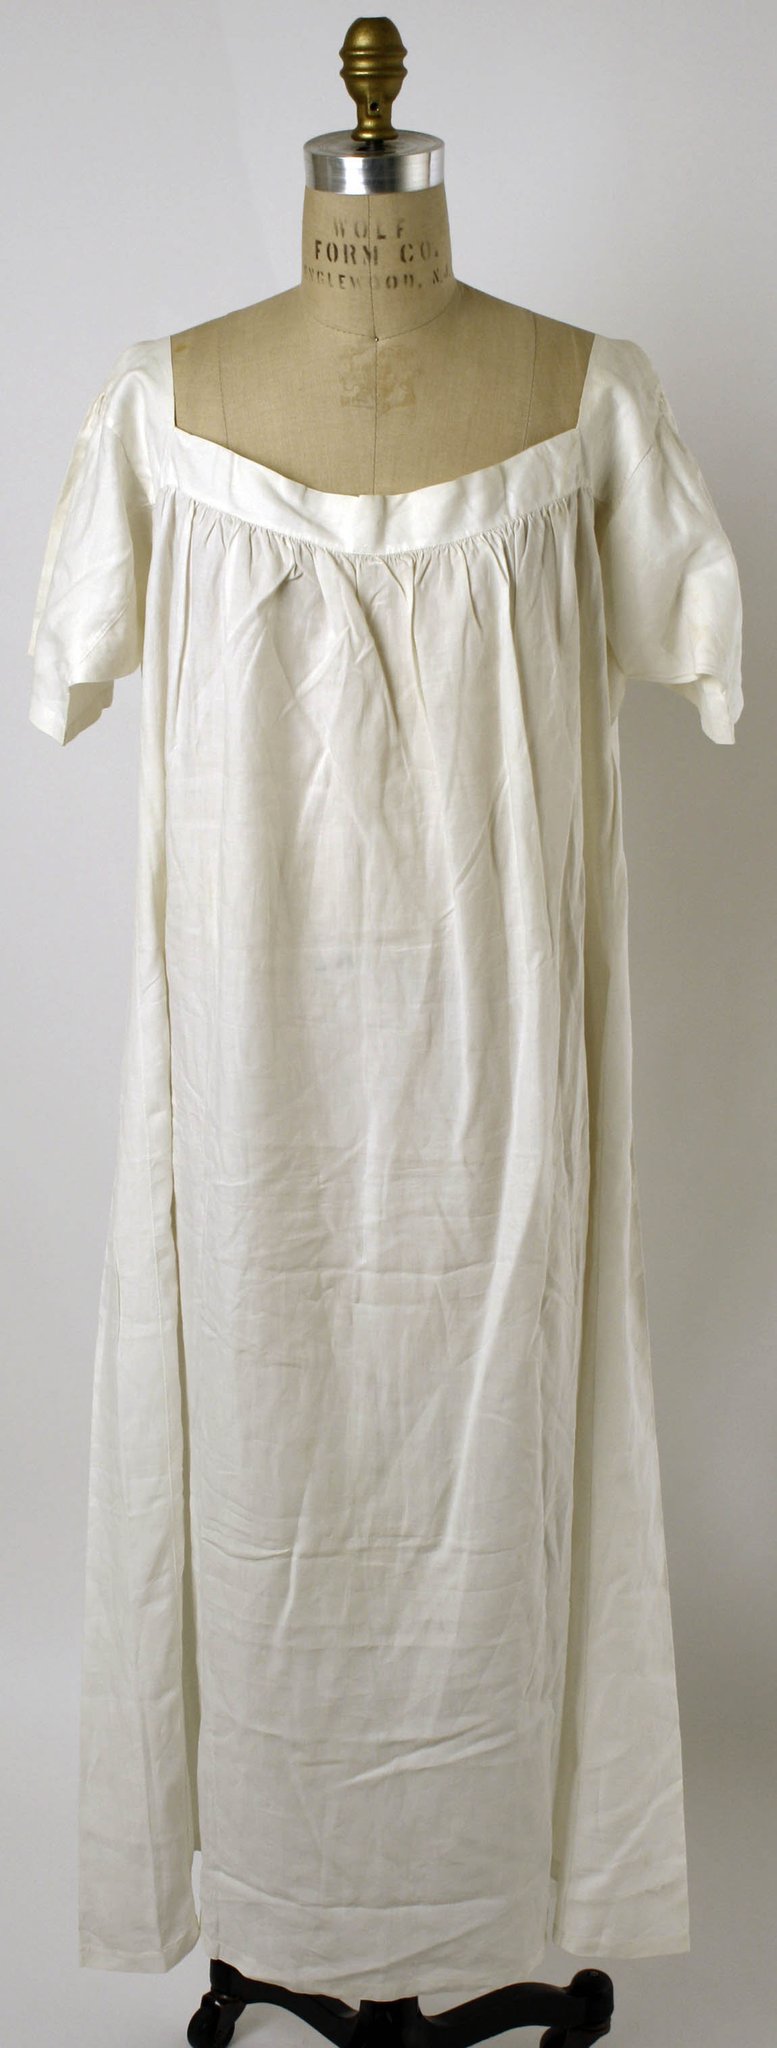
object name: nightgown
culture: american or european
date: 1859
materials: linen